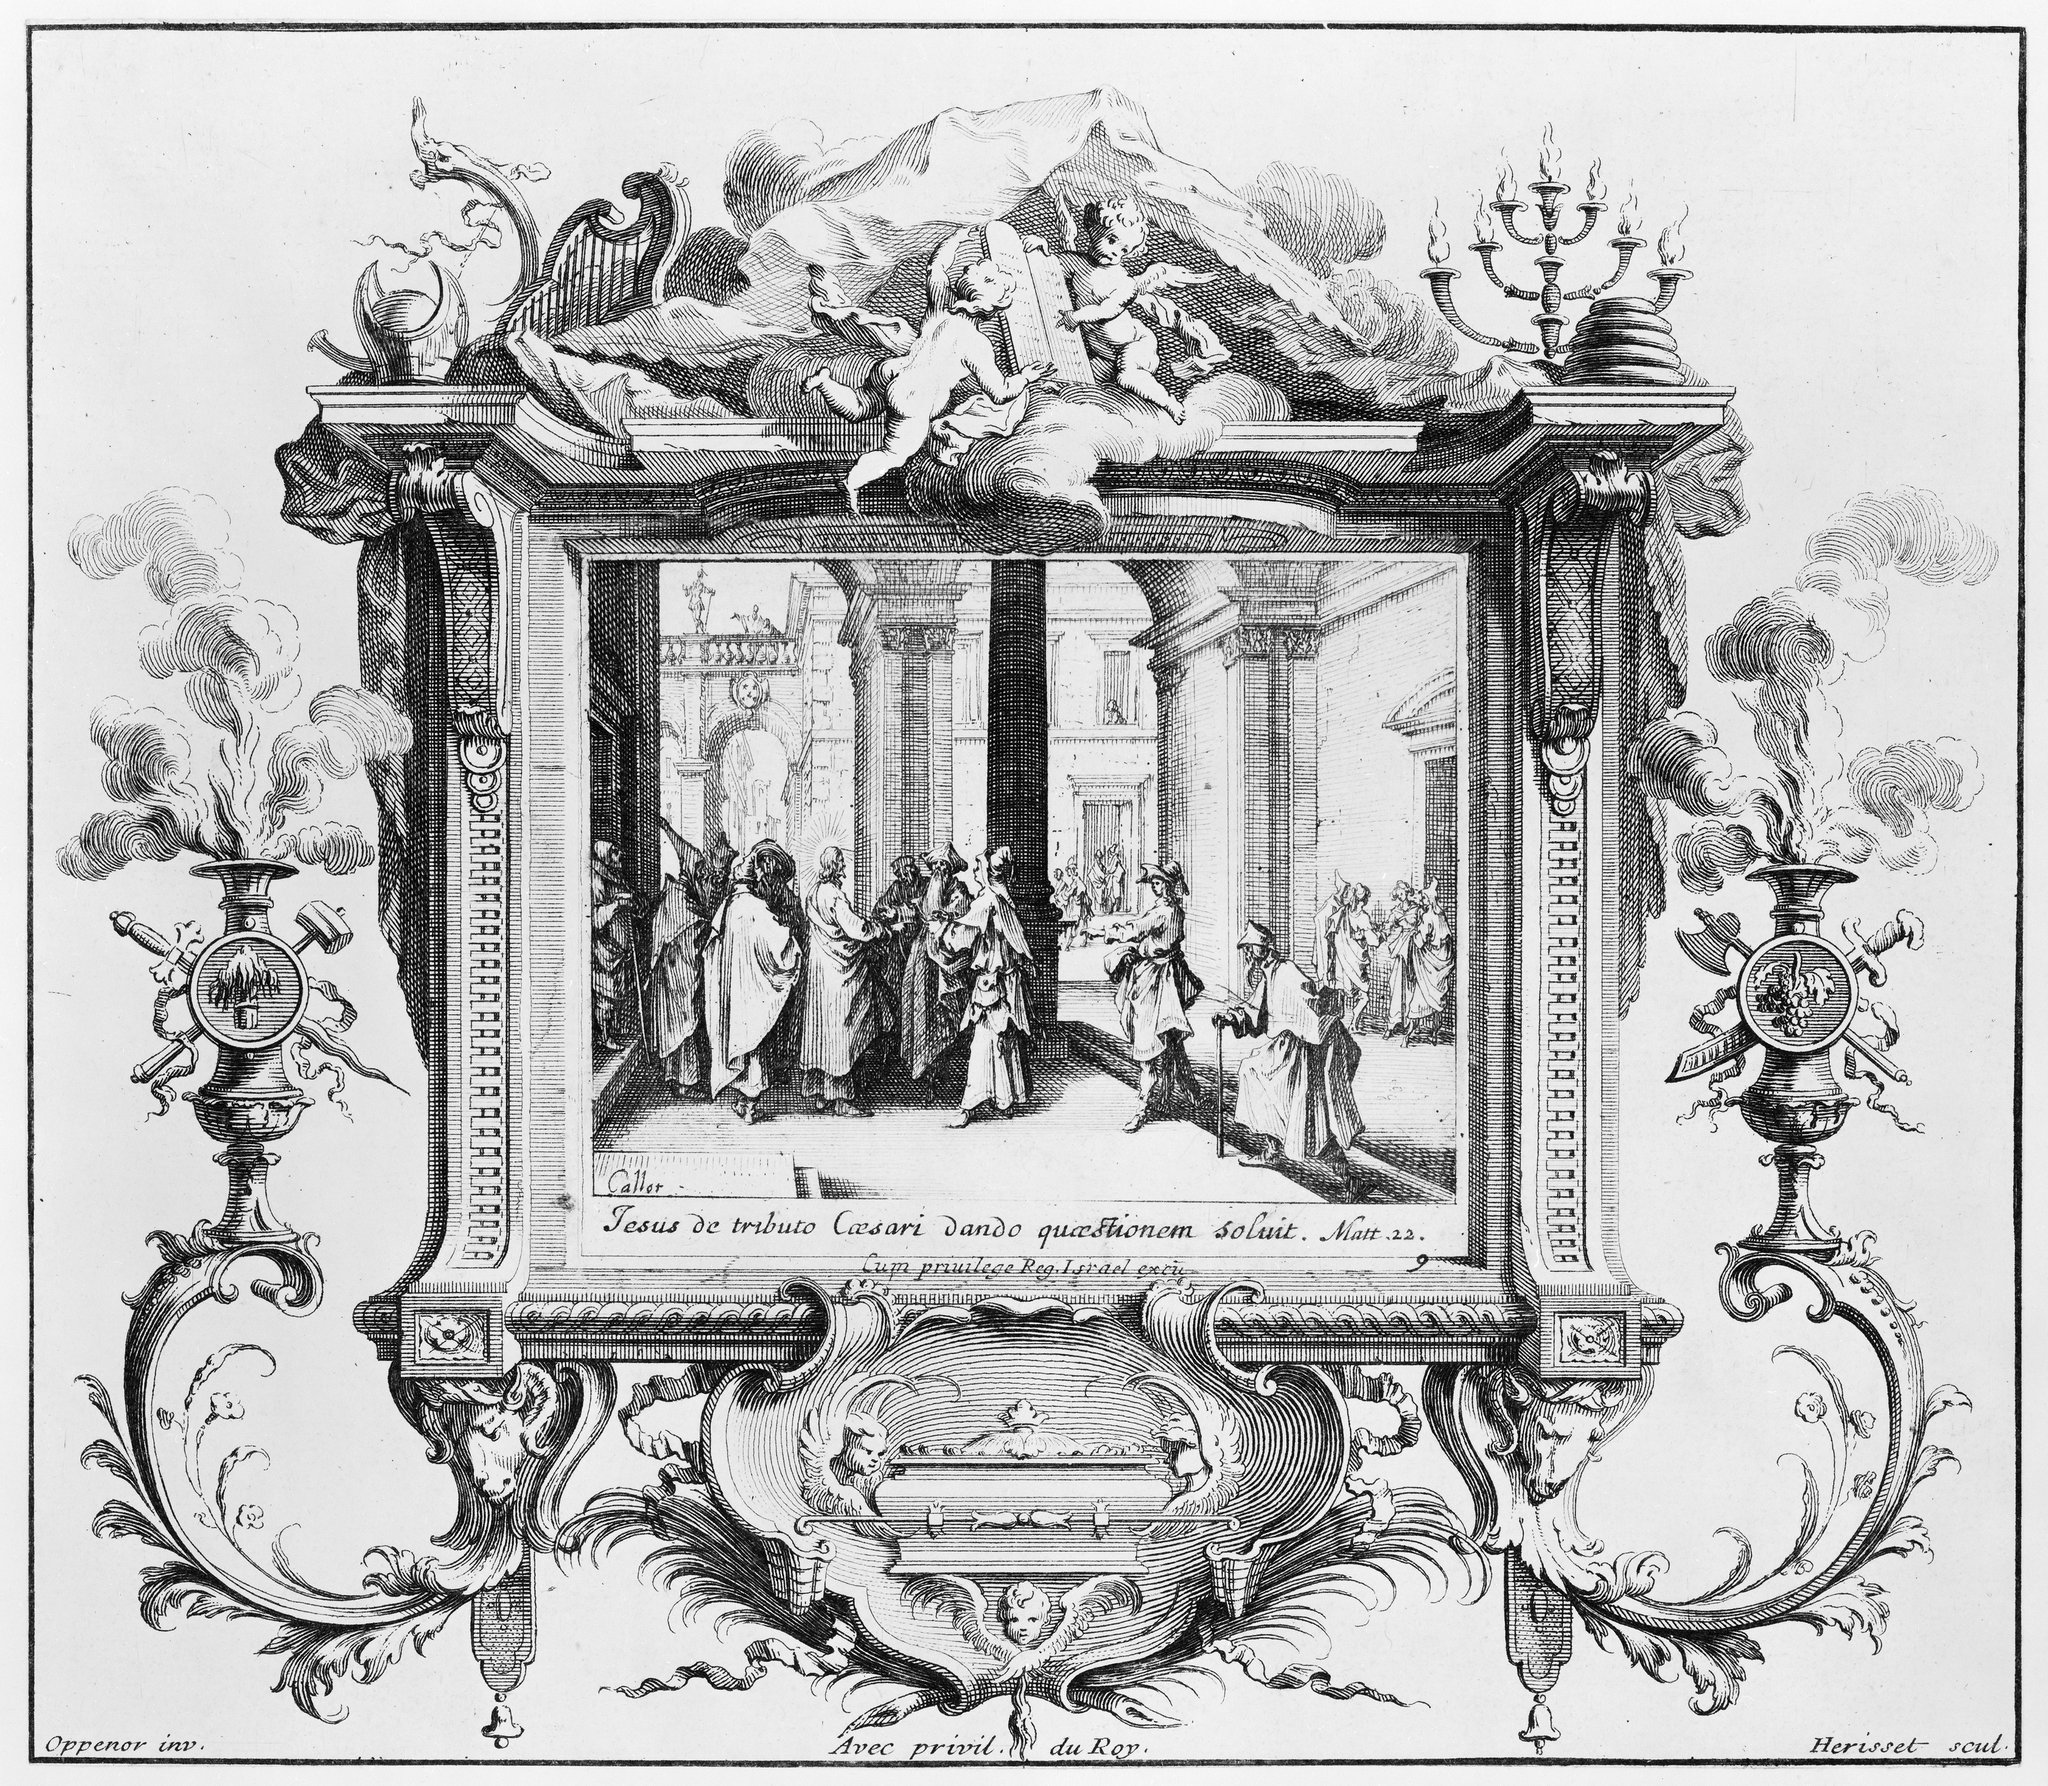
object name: print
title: Le Denier de César (The Tribute Money), from Le Nouveau Testament (The New Testament)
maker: jacques callot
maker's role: artist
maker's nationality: french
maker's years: 1592-1635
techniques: etching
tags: men,women,angels,jesus